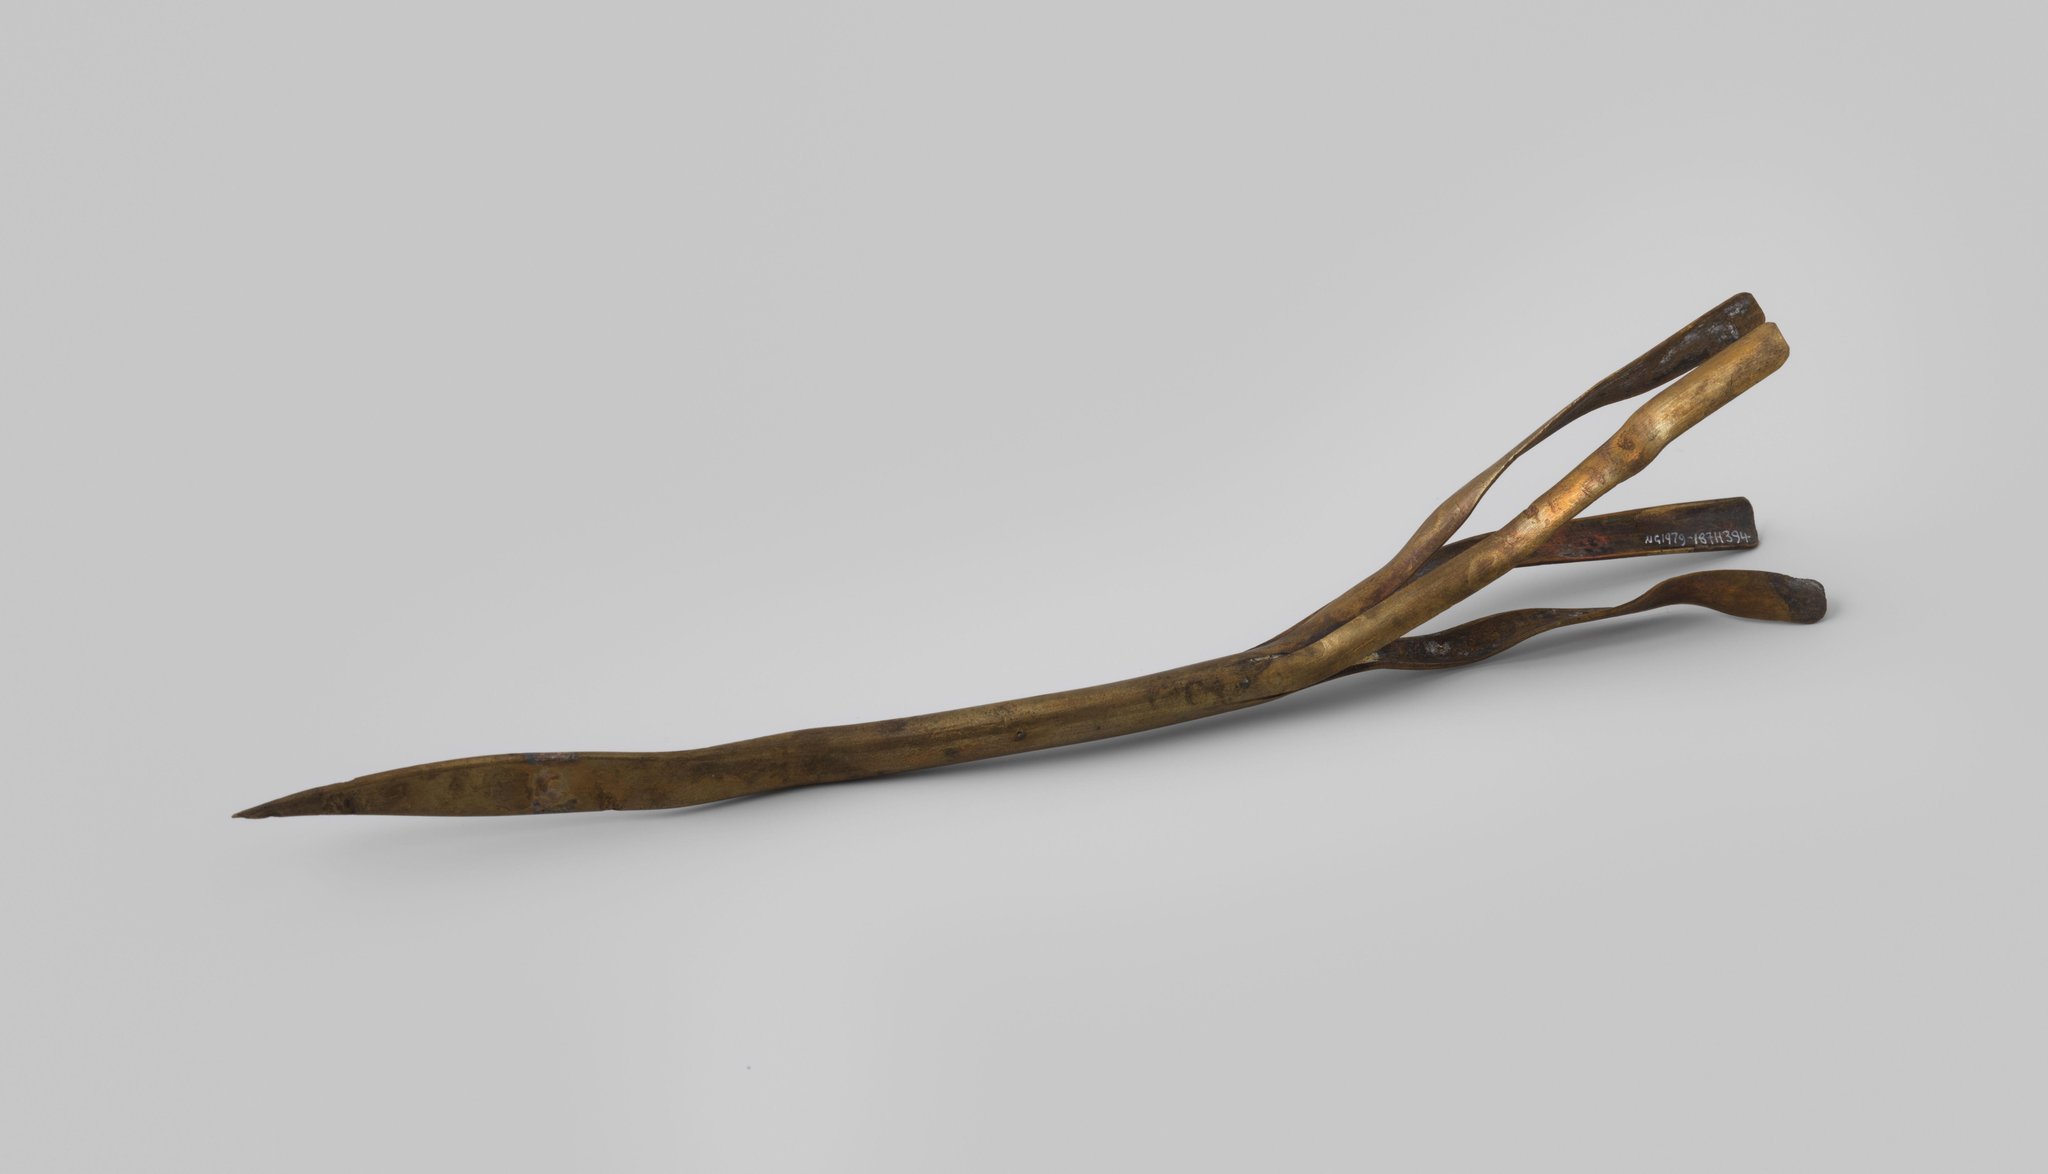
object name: needle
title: Sailmaker's needle Calking iron from the wreck of the Dutch East Indiaman Hollandia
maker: Anonymous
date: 1700-1743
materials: copper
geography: netherlands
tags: verenigde oostindische compagnie, hollandia (schip), annet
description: Tools and instruments, sewing and sailmaking, sailmaker's needle; tube, circular in section, flattened point on lower end, upper part ending in 4 splayed strips.